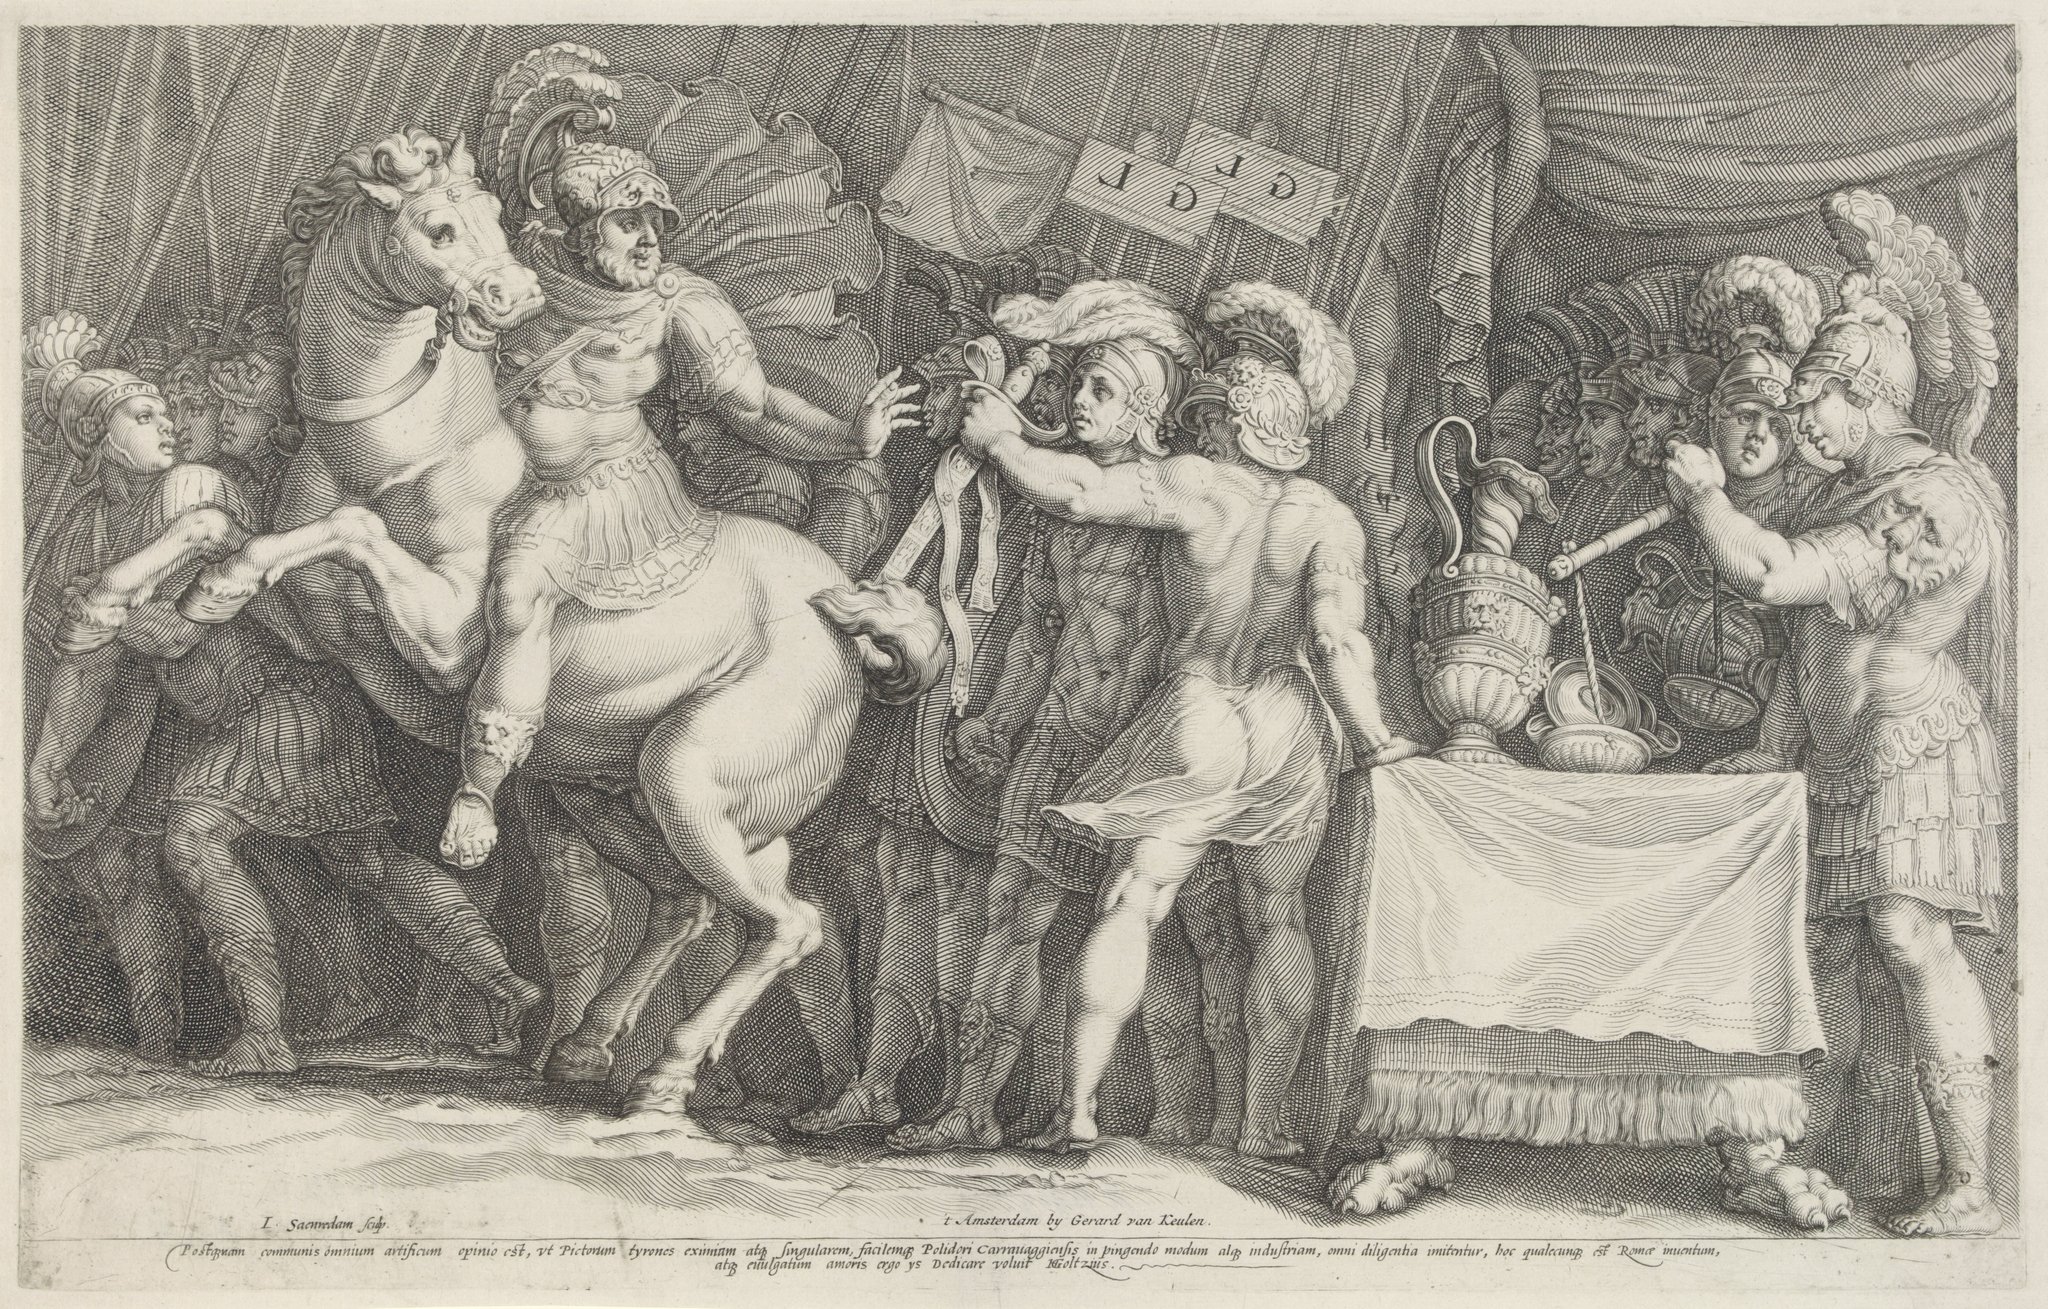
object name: print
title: Marcus Furius Camillus arriveert in Rome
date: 1717-1721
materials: paper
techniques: engraving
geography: amsterdam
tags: riding a horse, ass, or mule; rider, horseman, the soldier; the soldier's life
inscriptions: collector's mark: Lugt 2228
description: Marcus Furius Camillus komt aan in Rome om met de Galliërs te onderhandelen. Hij zit op een paard en reikt naar een zwaard, dat hem door een soldaat wordt aangereikt. Rechts staat een groep gewapende soldaten achter een tafel, van wie één waardevolle spullen weegt. Onder de voorstelling een tweeregelige, Latijnse tekst.